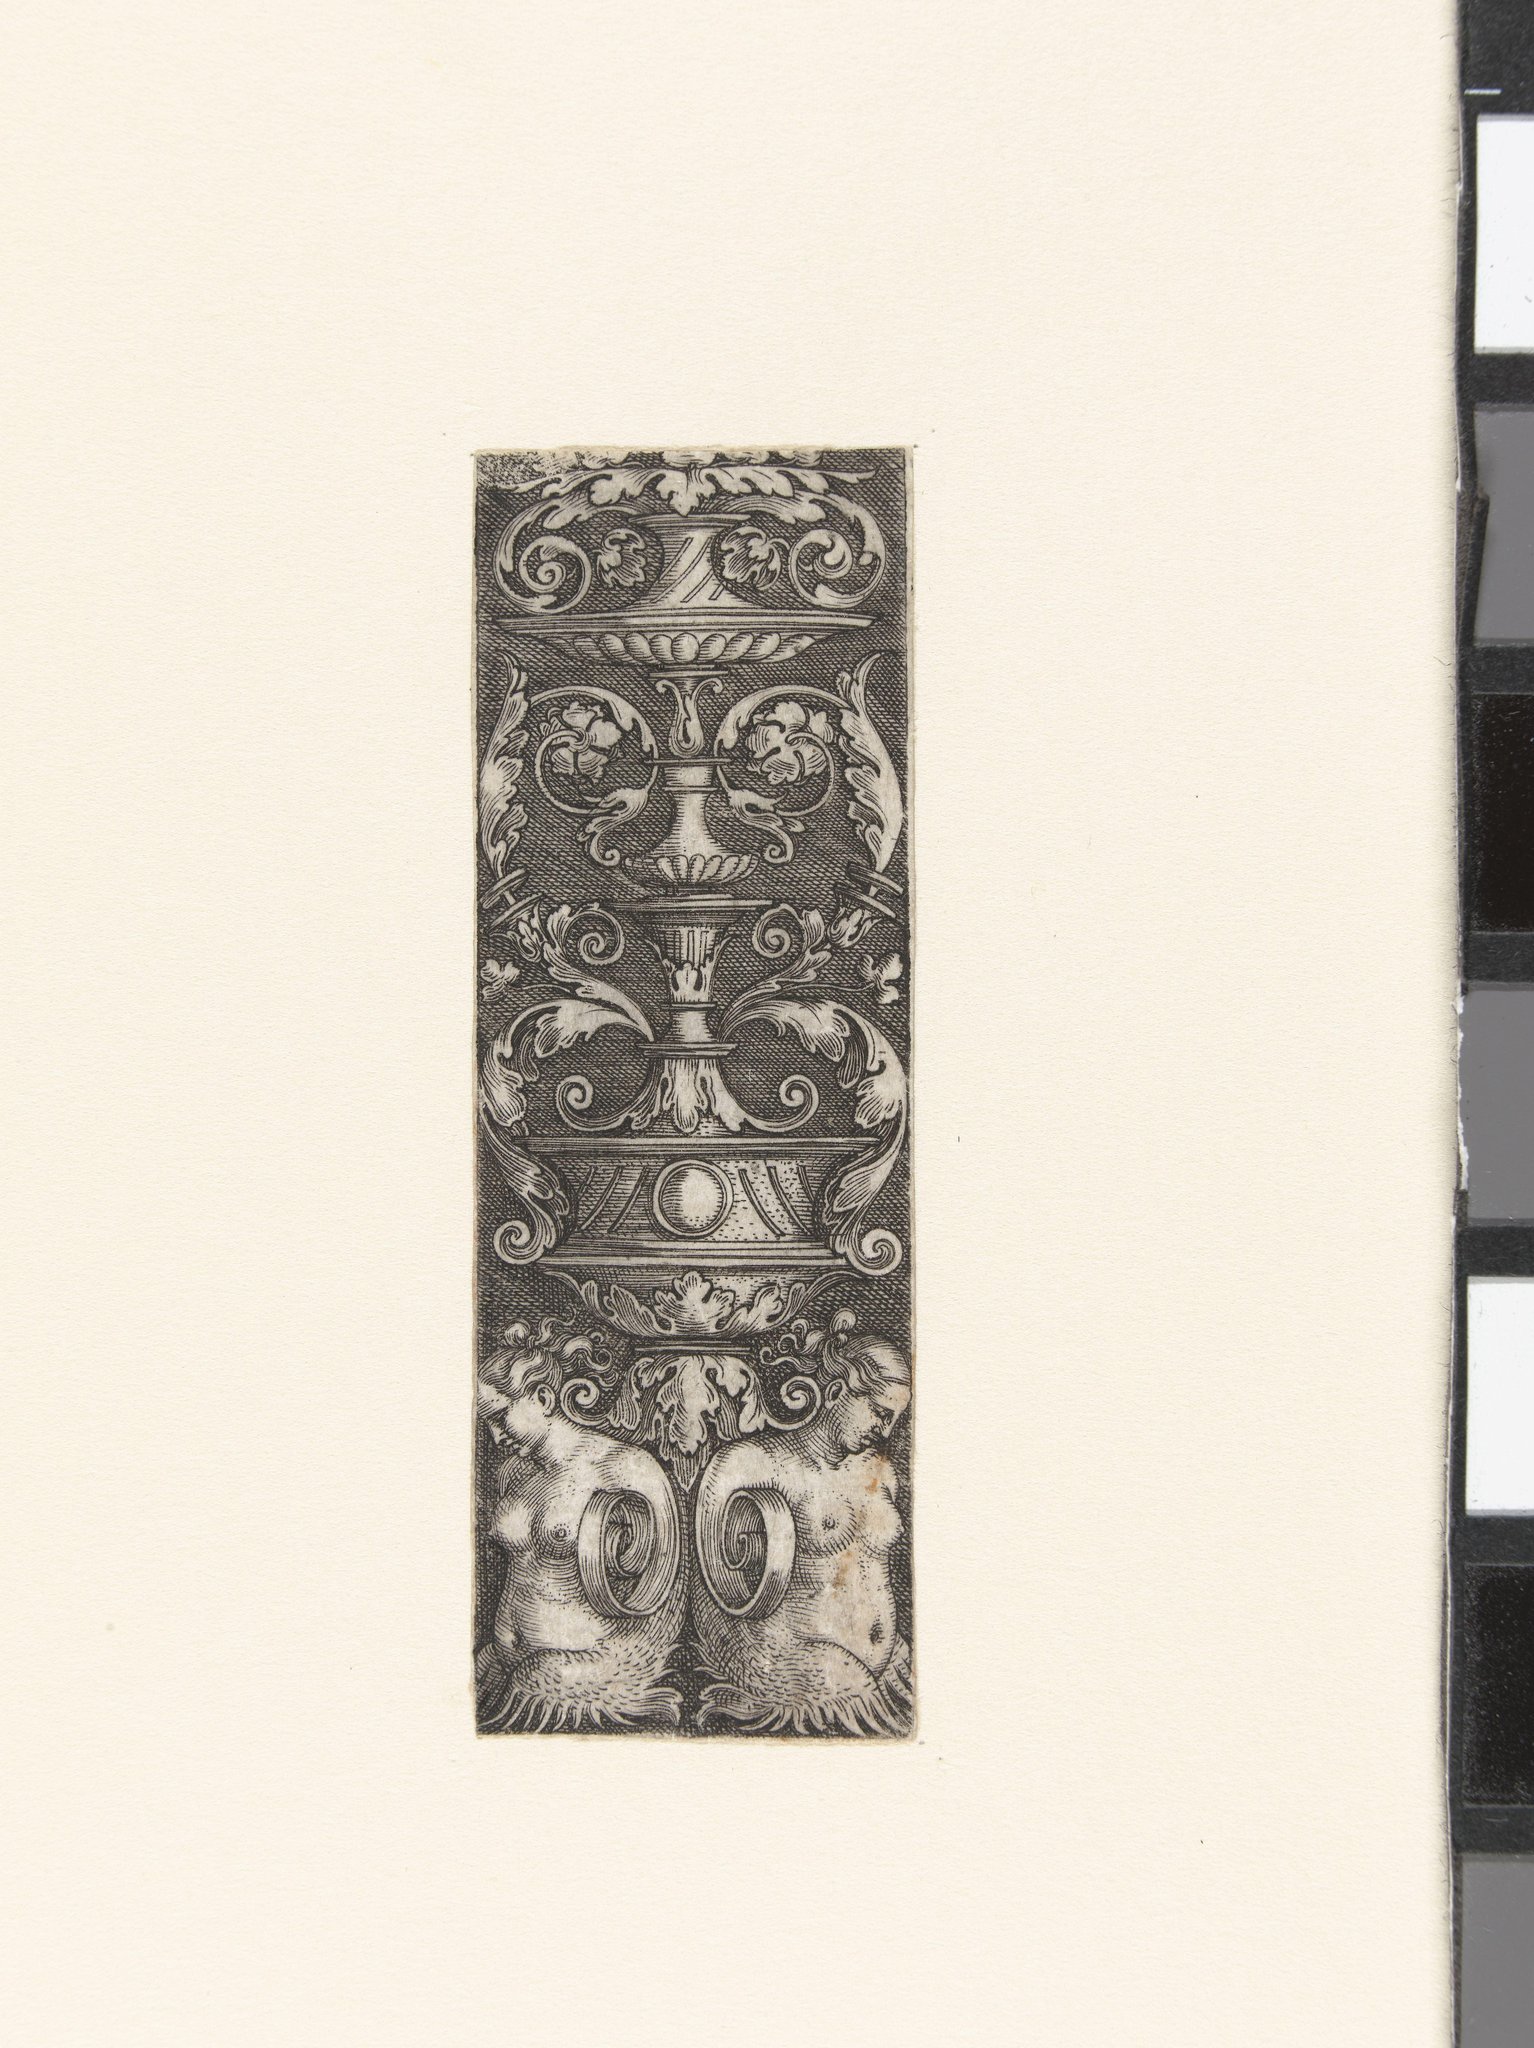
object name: print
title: Kandelaber met bladranken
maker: Anonymous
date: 1512-1540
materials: paper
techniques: engraving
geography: germany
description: Vlakdecoratie. De kandelaber wordt door twee vrouwen rug aan rug gedragen. Zij hebben voluten in plaats van armen. Gearceerde achtergrond.